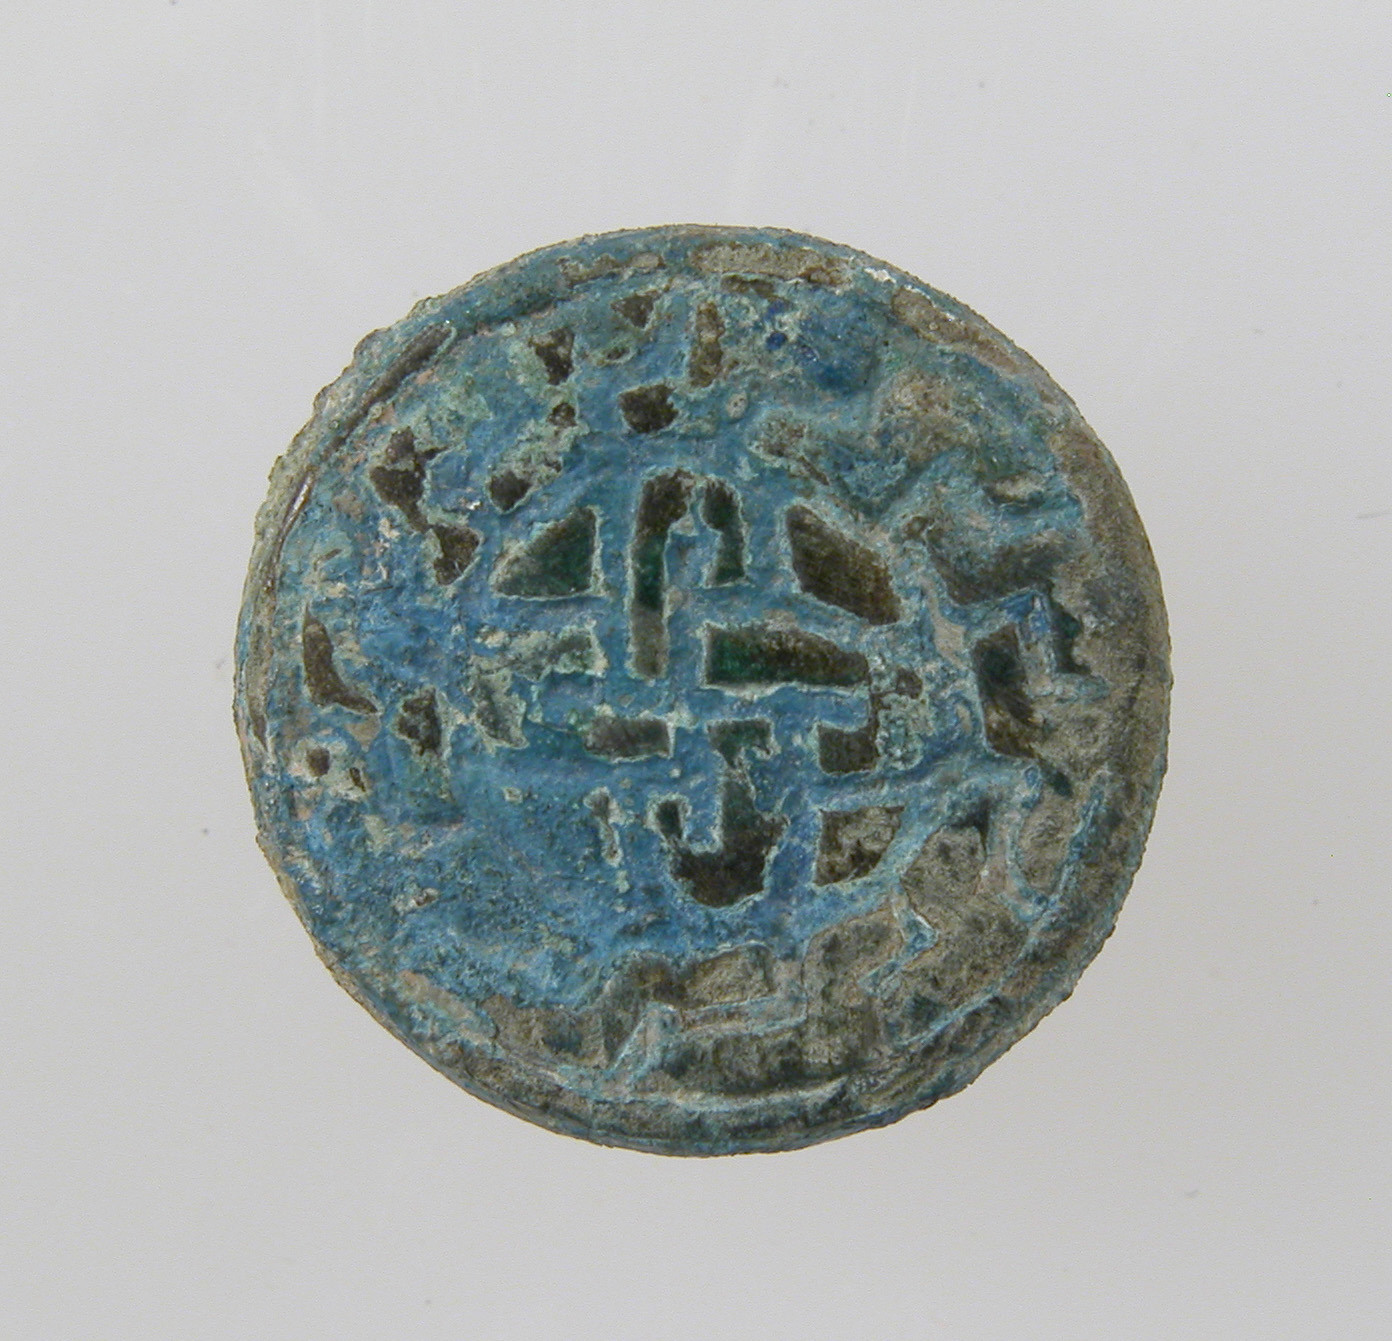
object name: stud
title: Small Circular Stud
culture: frankish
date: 601-650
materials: copper alloy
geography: germany